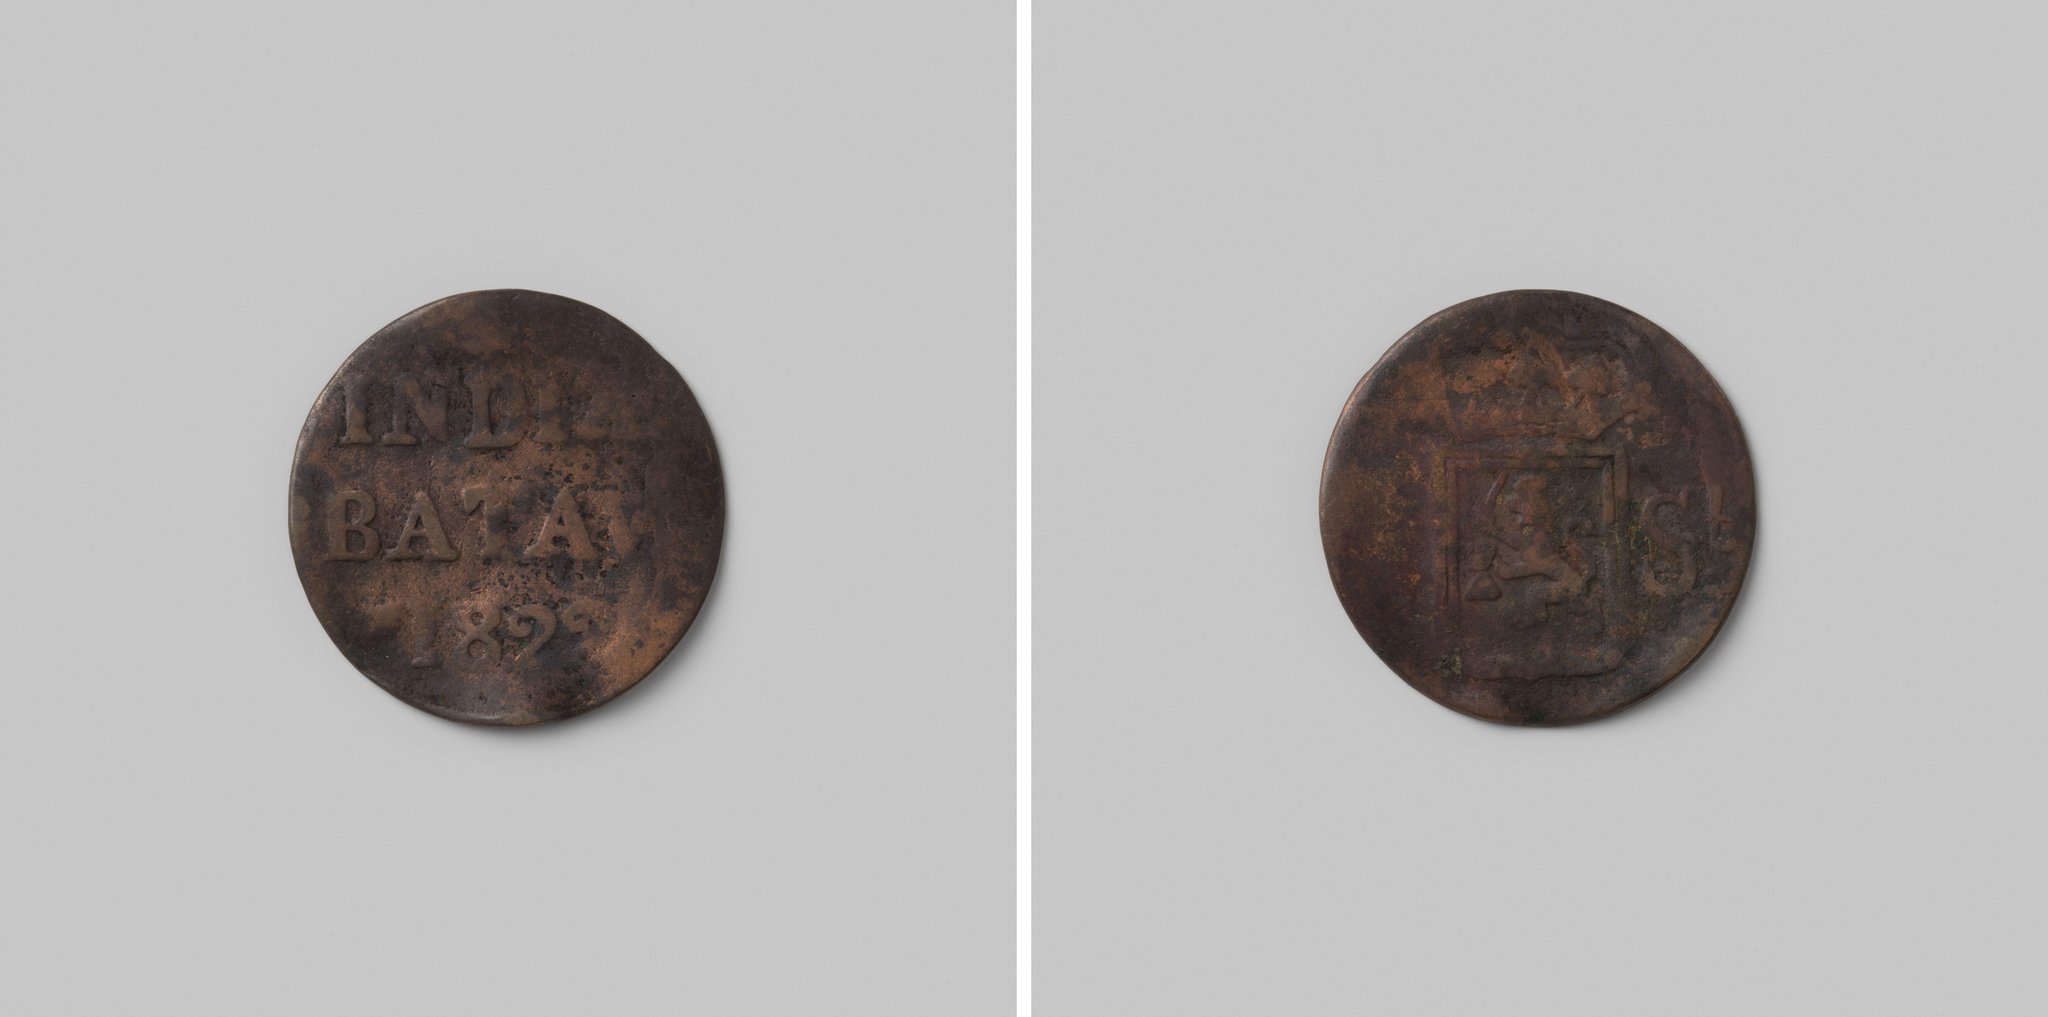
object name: coin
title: Koperen 2 cent VOC-munt uit 1822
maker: Anonymous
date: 1822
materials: copper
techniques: striking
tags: dutch east indies, the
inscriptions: inscription: ‘Jacques Schulman / Numismaat / Keizersgracht 448 / Amsterdam-C.’, inscription: ‘INDIA / BATAV / 1822’, inscription: ‘St’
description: Koperen 2 cent VOC-muntje uit Nederlands-Indië uit1822. Voorzijde: opschrift. Keerzijde: een gekroond wapen met leeuw erin en rechts ervan staan de letters ' St' . Het muntje zit in een vierkant envelopje met opschrift.